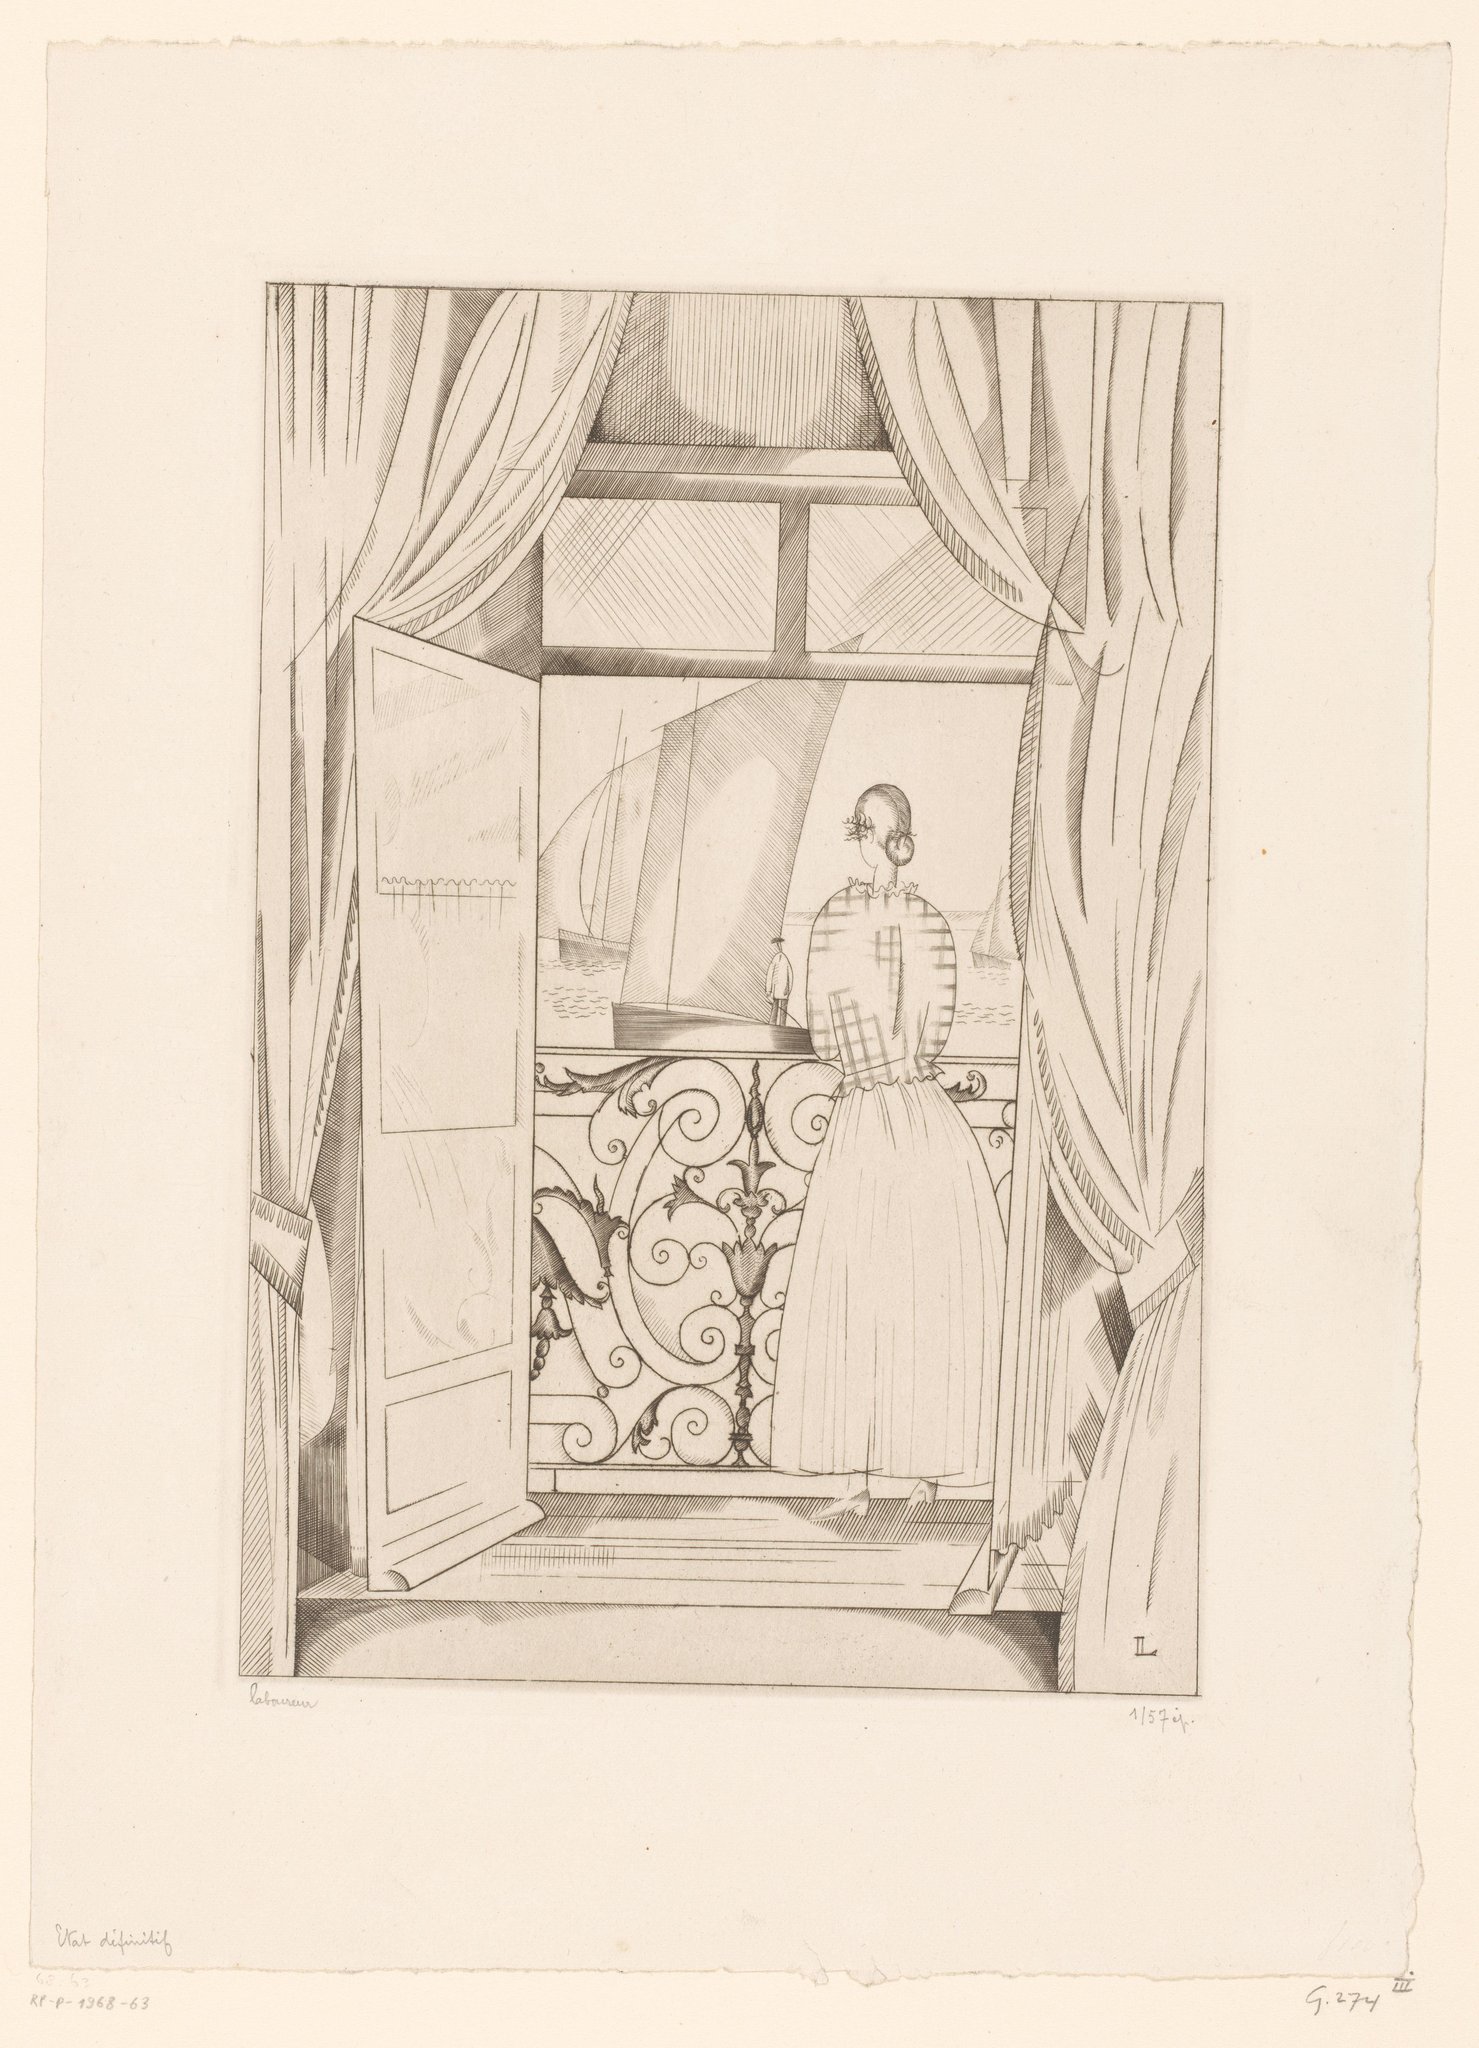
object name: print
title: Zeezicht door een raam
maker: jean emile laboureur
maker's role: draughtsman, print maker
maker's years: 1877-1943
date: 1923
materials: paper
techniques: drypoint, engraving, intaglio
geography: france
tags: sea (seascape), human figure at (open) window, seen from inside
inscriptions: collector's mark: Lugt 2228, collector's mark: Lugt 2760